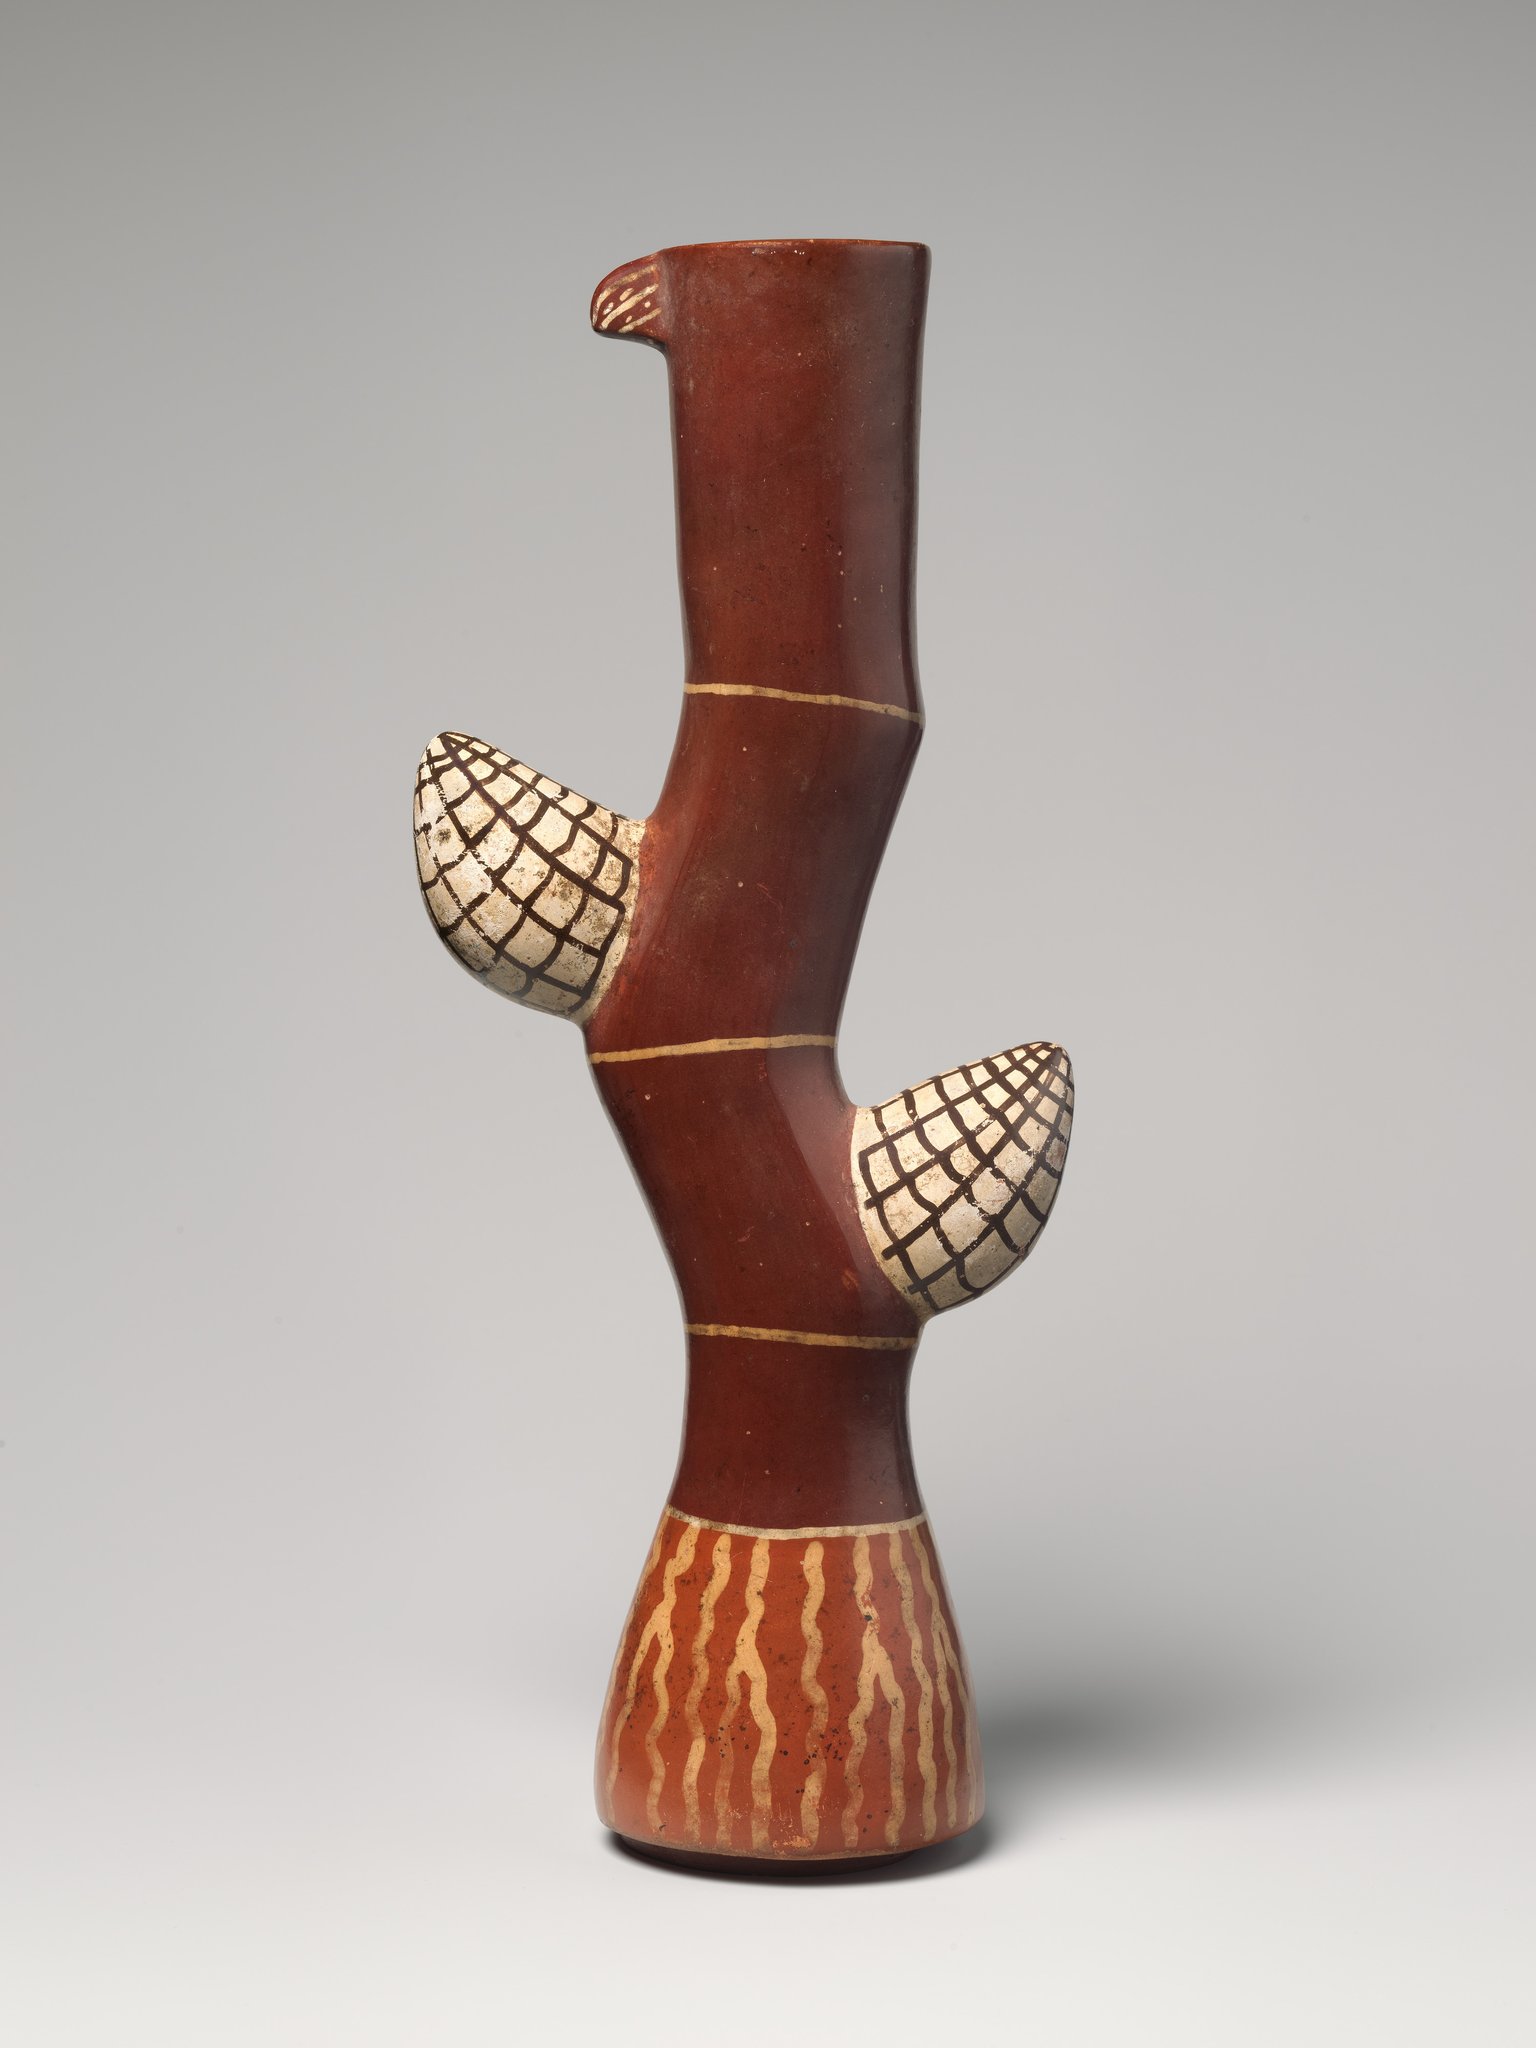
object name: bottle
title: Corn stalk-shaped vessel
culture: nasca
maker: nasca artist(s)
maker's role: artist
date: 1-600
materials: ceramic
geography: peru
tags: corn